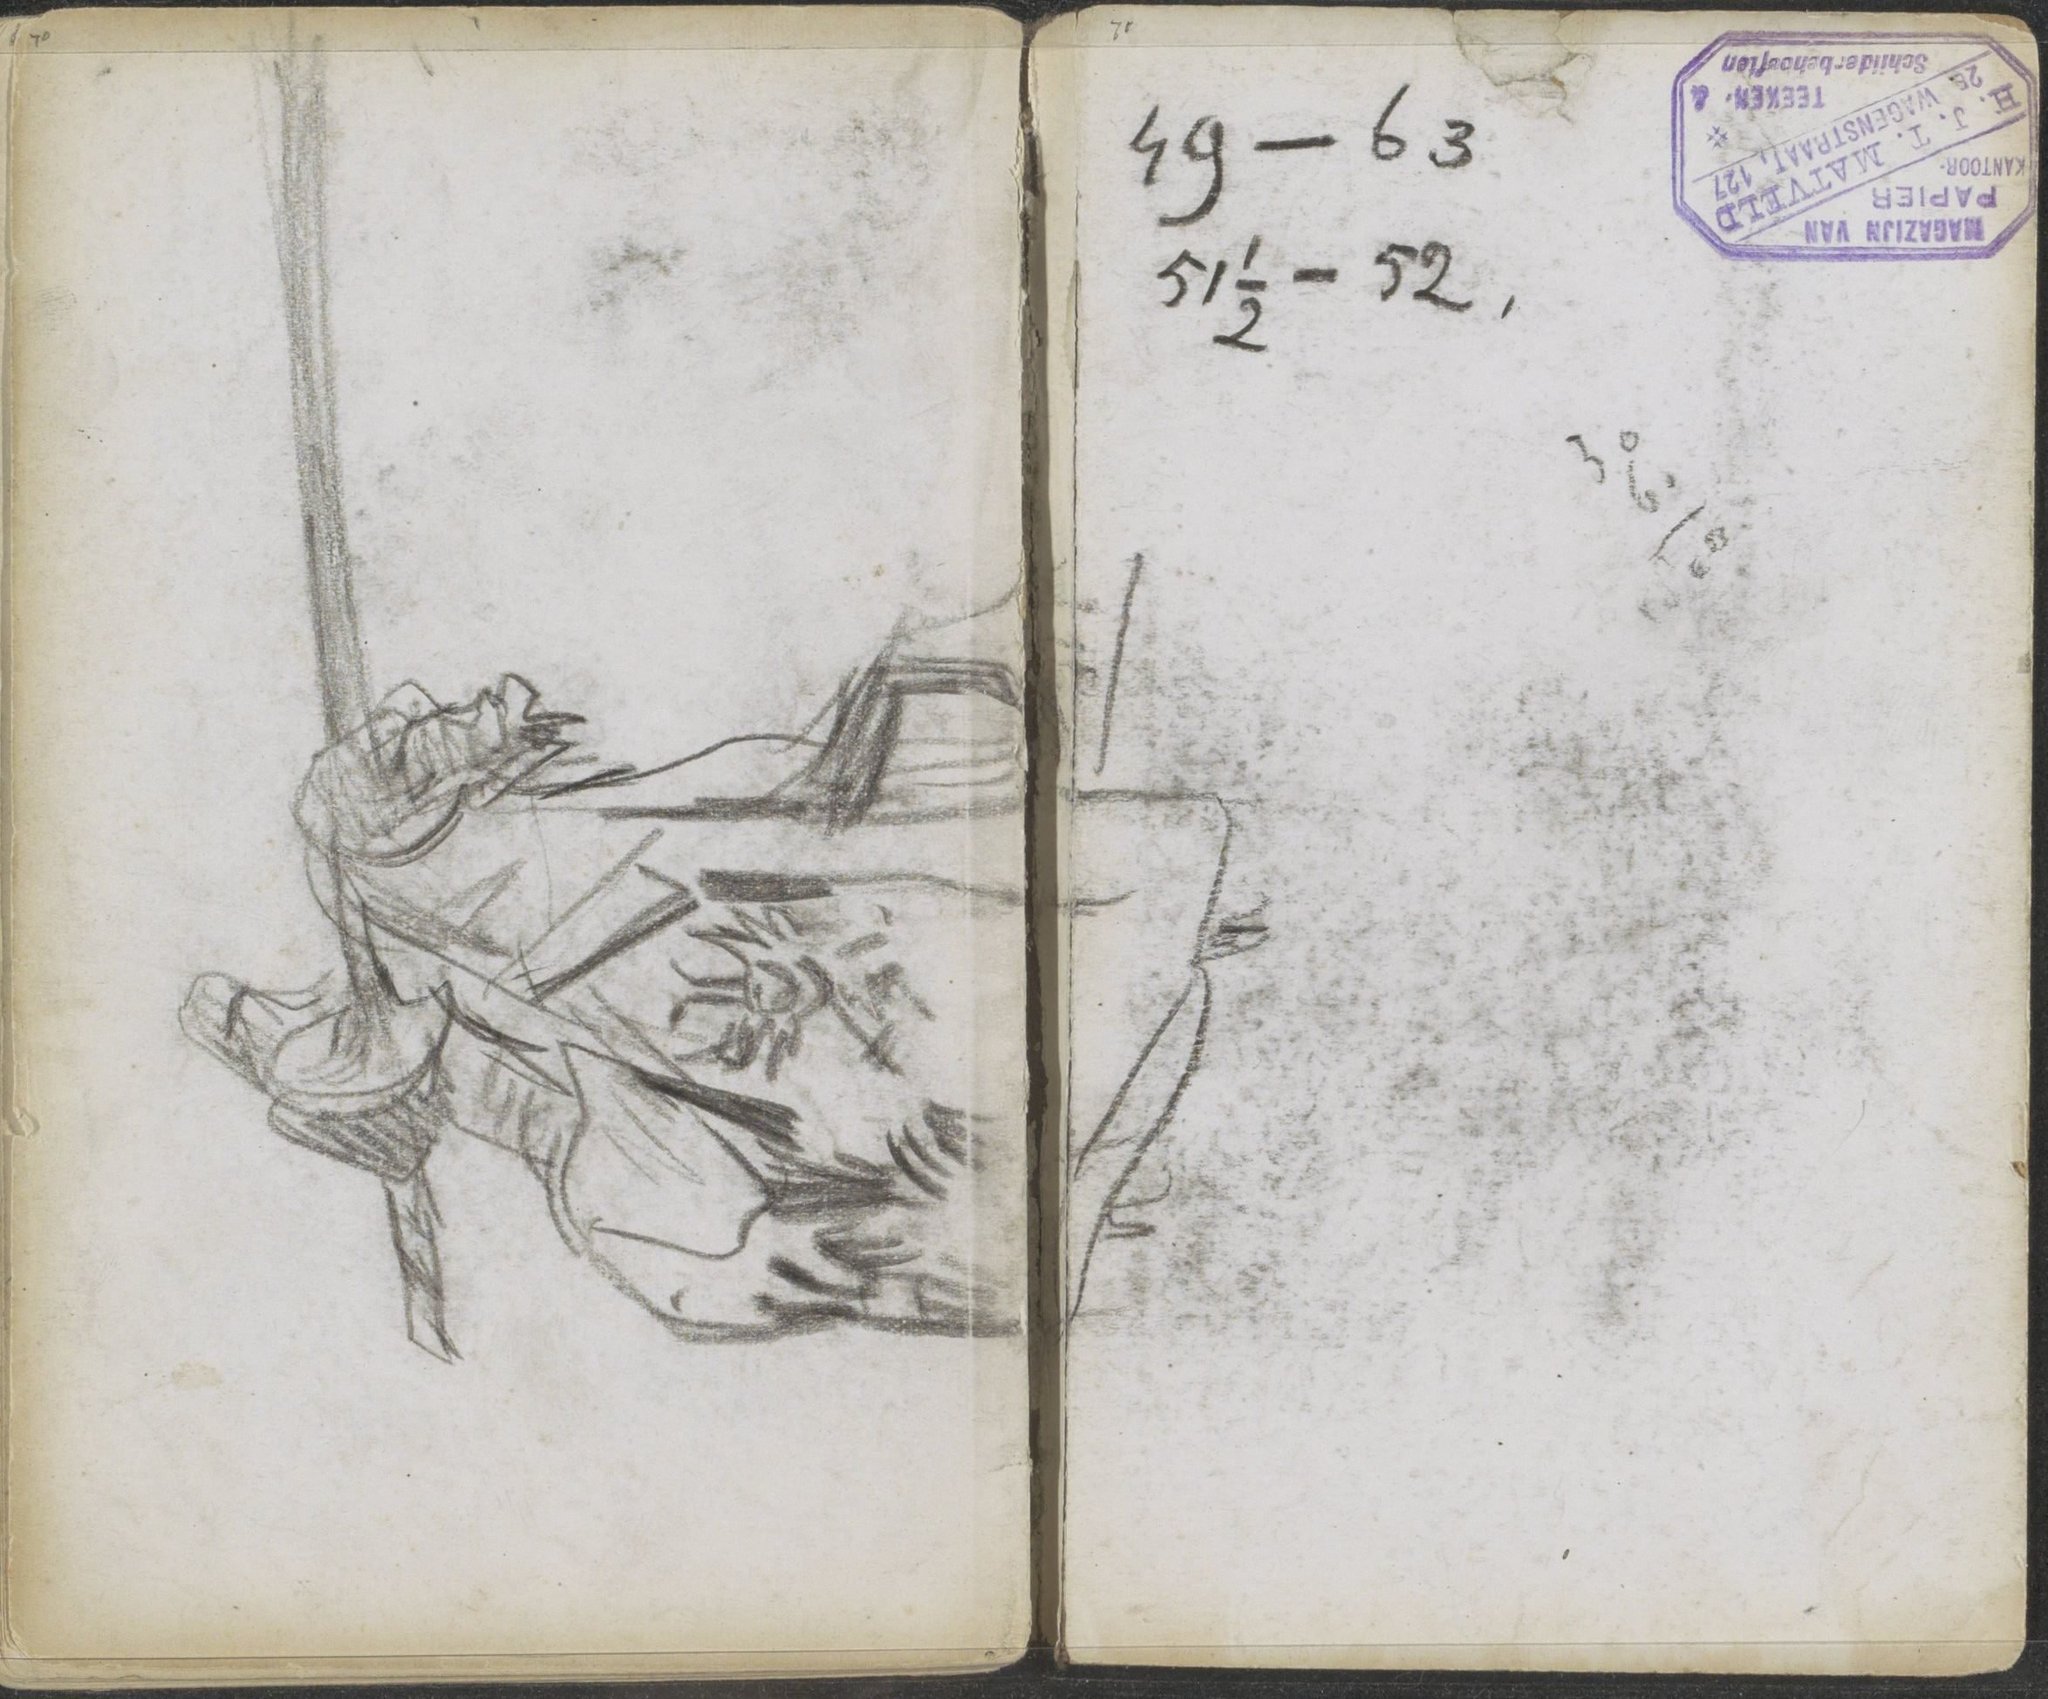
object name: sketchbook leaf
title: Blad met notities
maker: marius bauer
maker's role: draughtsman, print maker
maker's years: 1867-1932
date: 1810-1891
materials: charcoal, paper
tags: helmet, riding a horse, ass, or mule; rider, horseman, armour, knight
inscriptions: annotation: ‘49 - 63/ 51 1/2 - 52. [...]’, retailer's mark: ‘Magazijn van/ Papier/ Kantoor-/ H.J.T. Matveld/ 2E Wagenstraat, 127/ Teeken- &/ Schilderbehoeften’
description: Pagina 71, achterste schutblad, uit een schetsboek met 35 bladen.